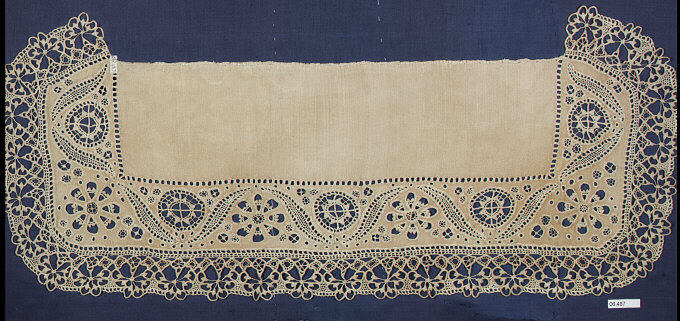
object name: headdress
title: Headdress (Coiffe)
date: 1701-1800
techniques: embroidery